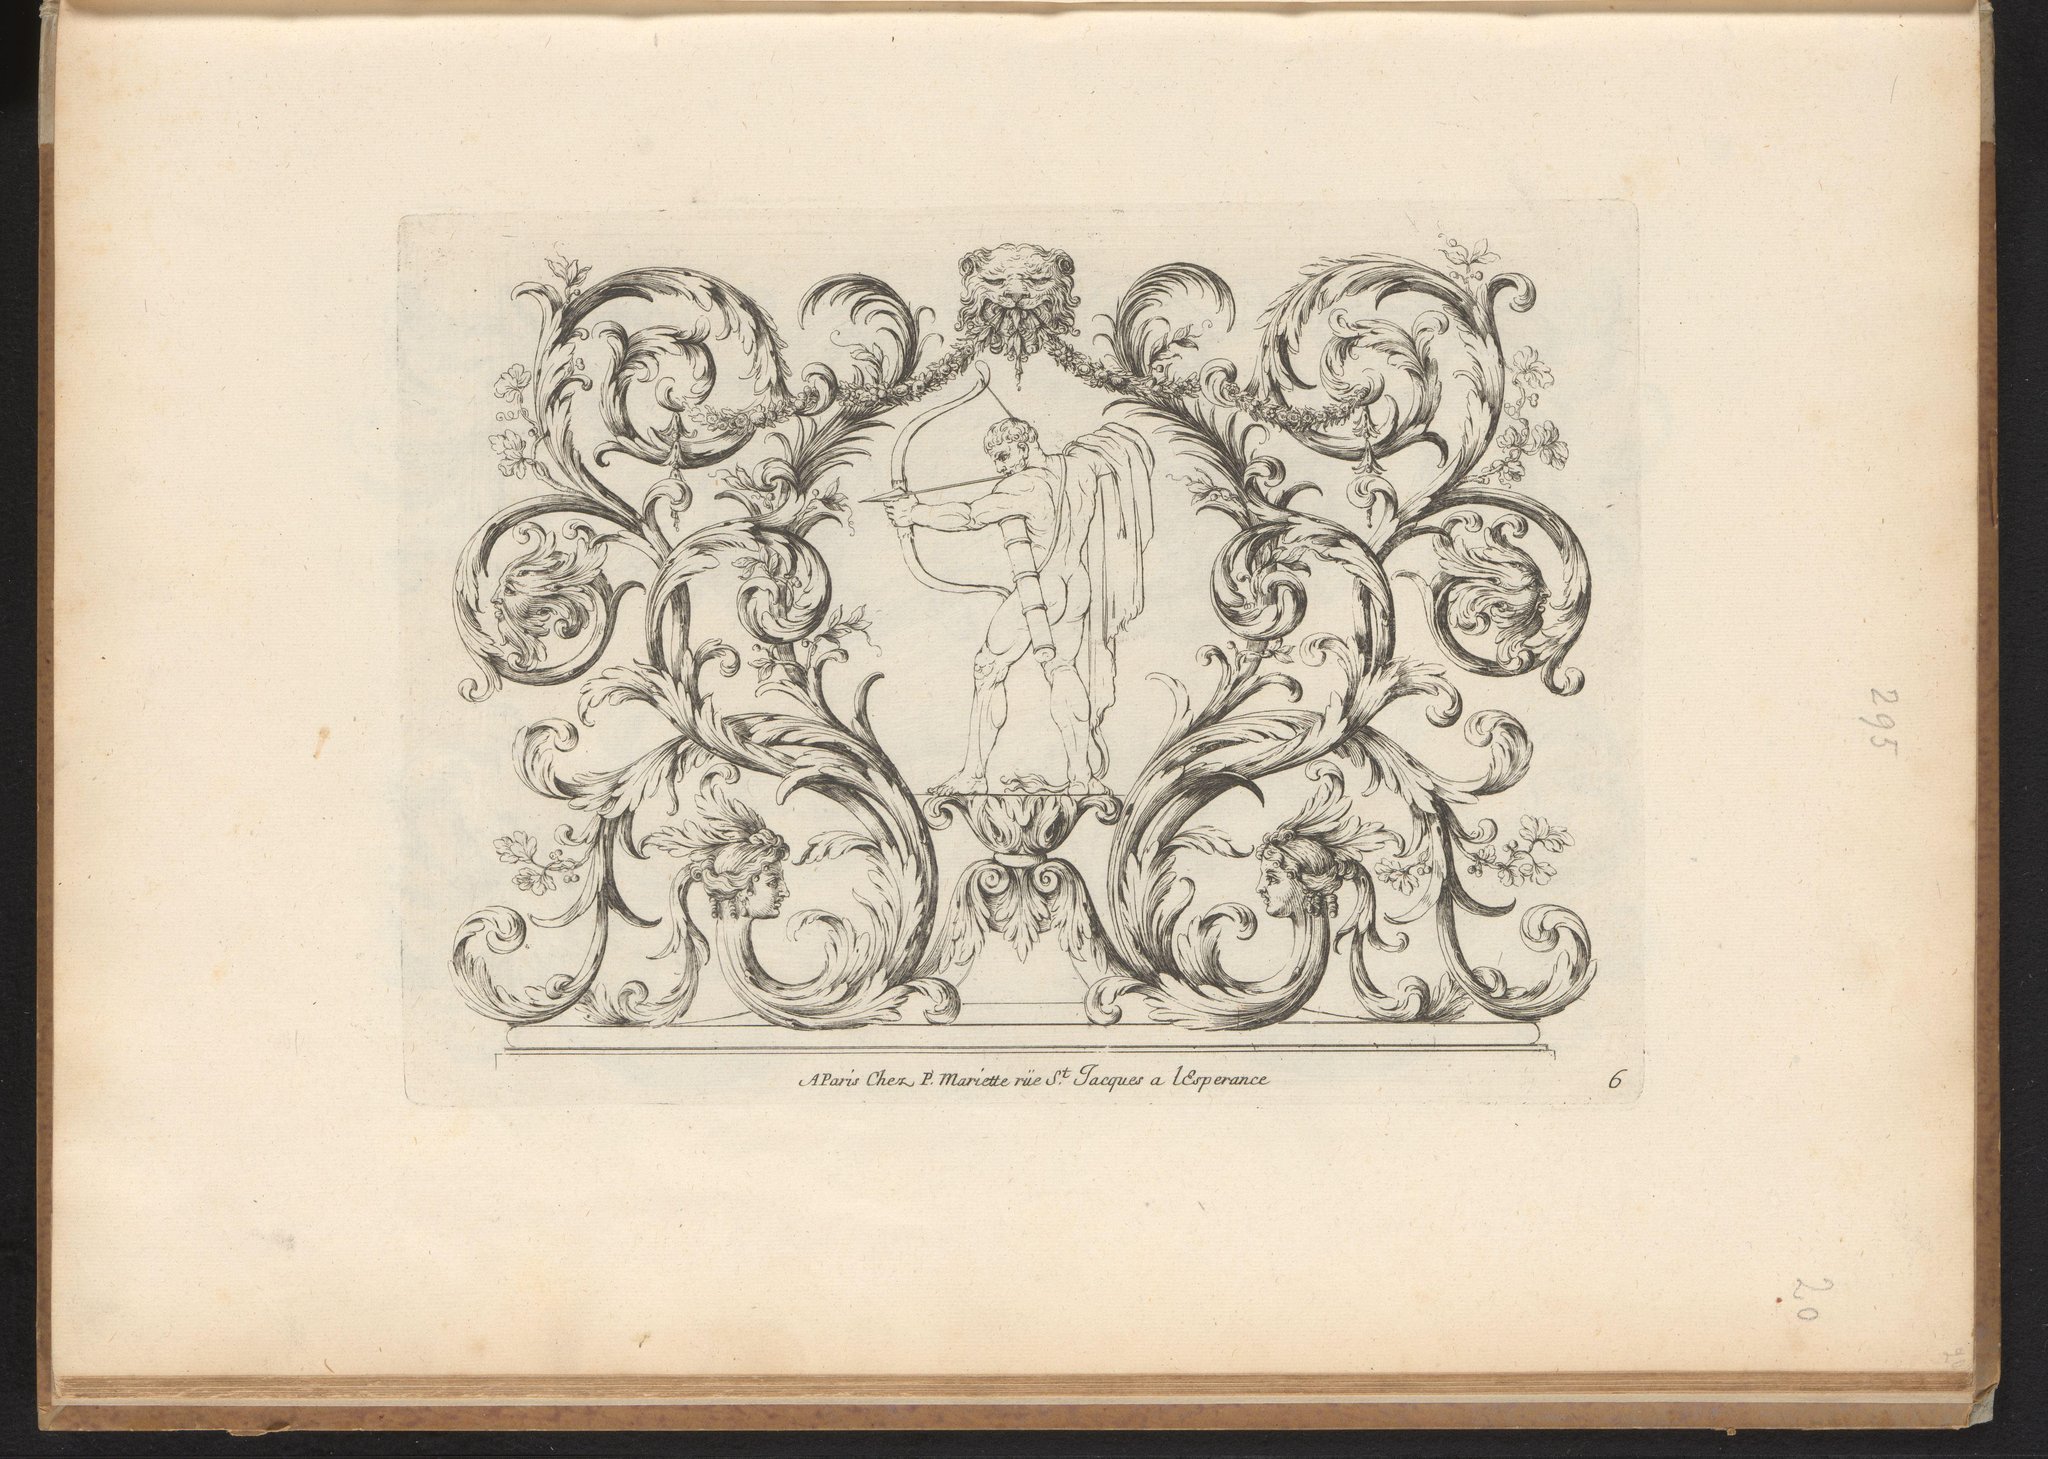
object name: ornament print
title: Panelen met bladmotieven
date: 1660-1690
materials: paper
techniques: etching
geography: paris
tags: (story of) hercules (heracles), acanthus ~ ornament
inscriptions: collector's mark: Lugt 2228a, collector's mark: Lugt 2760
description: Deze prent maakt deel uit van een album.